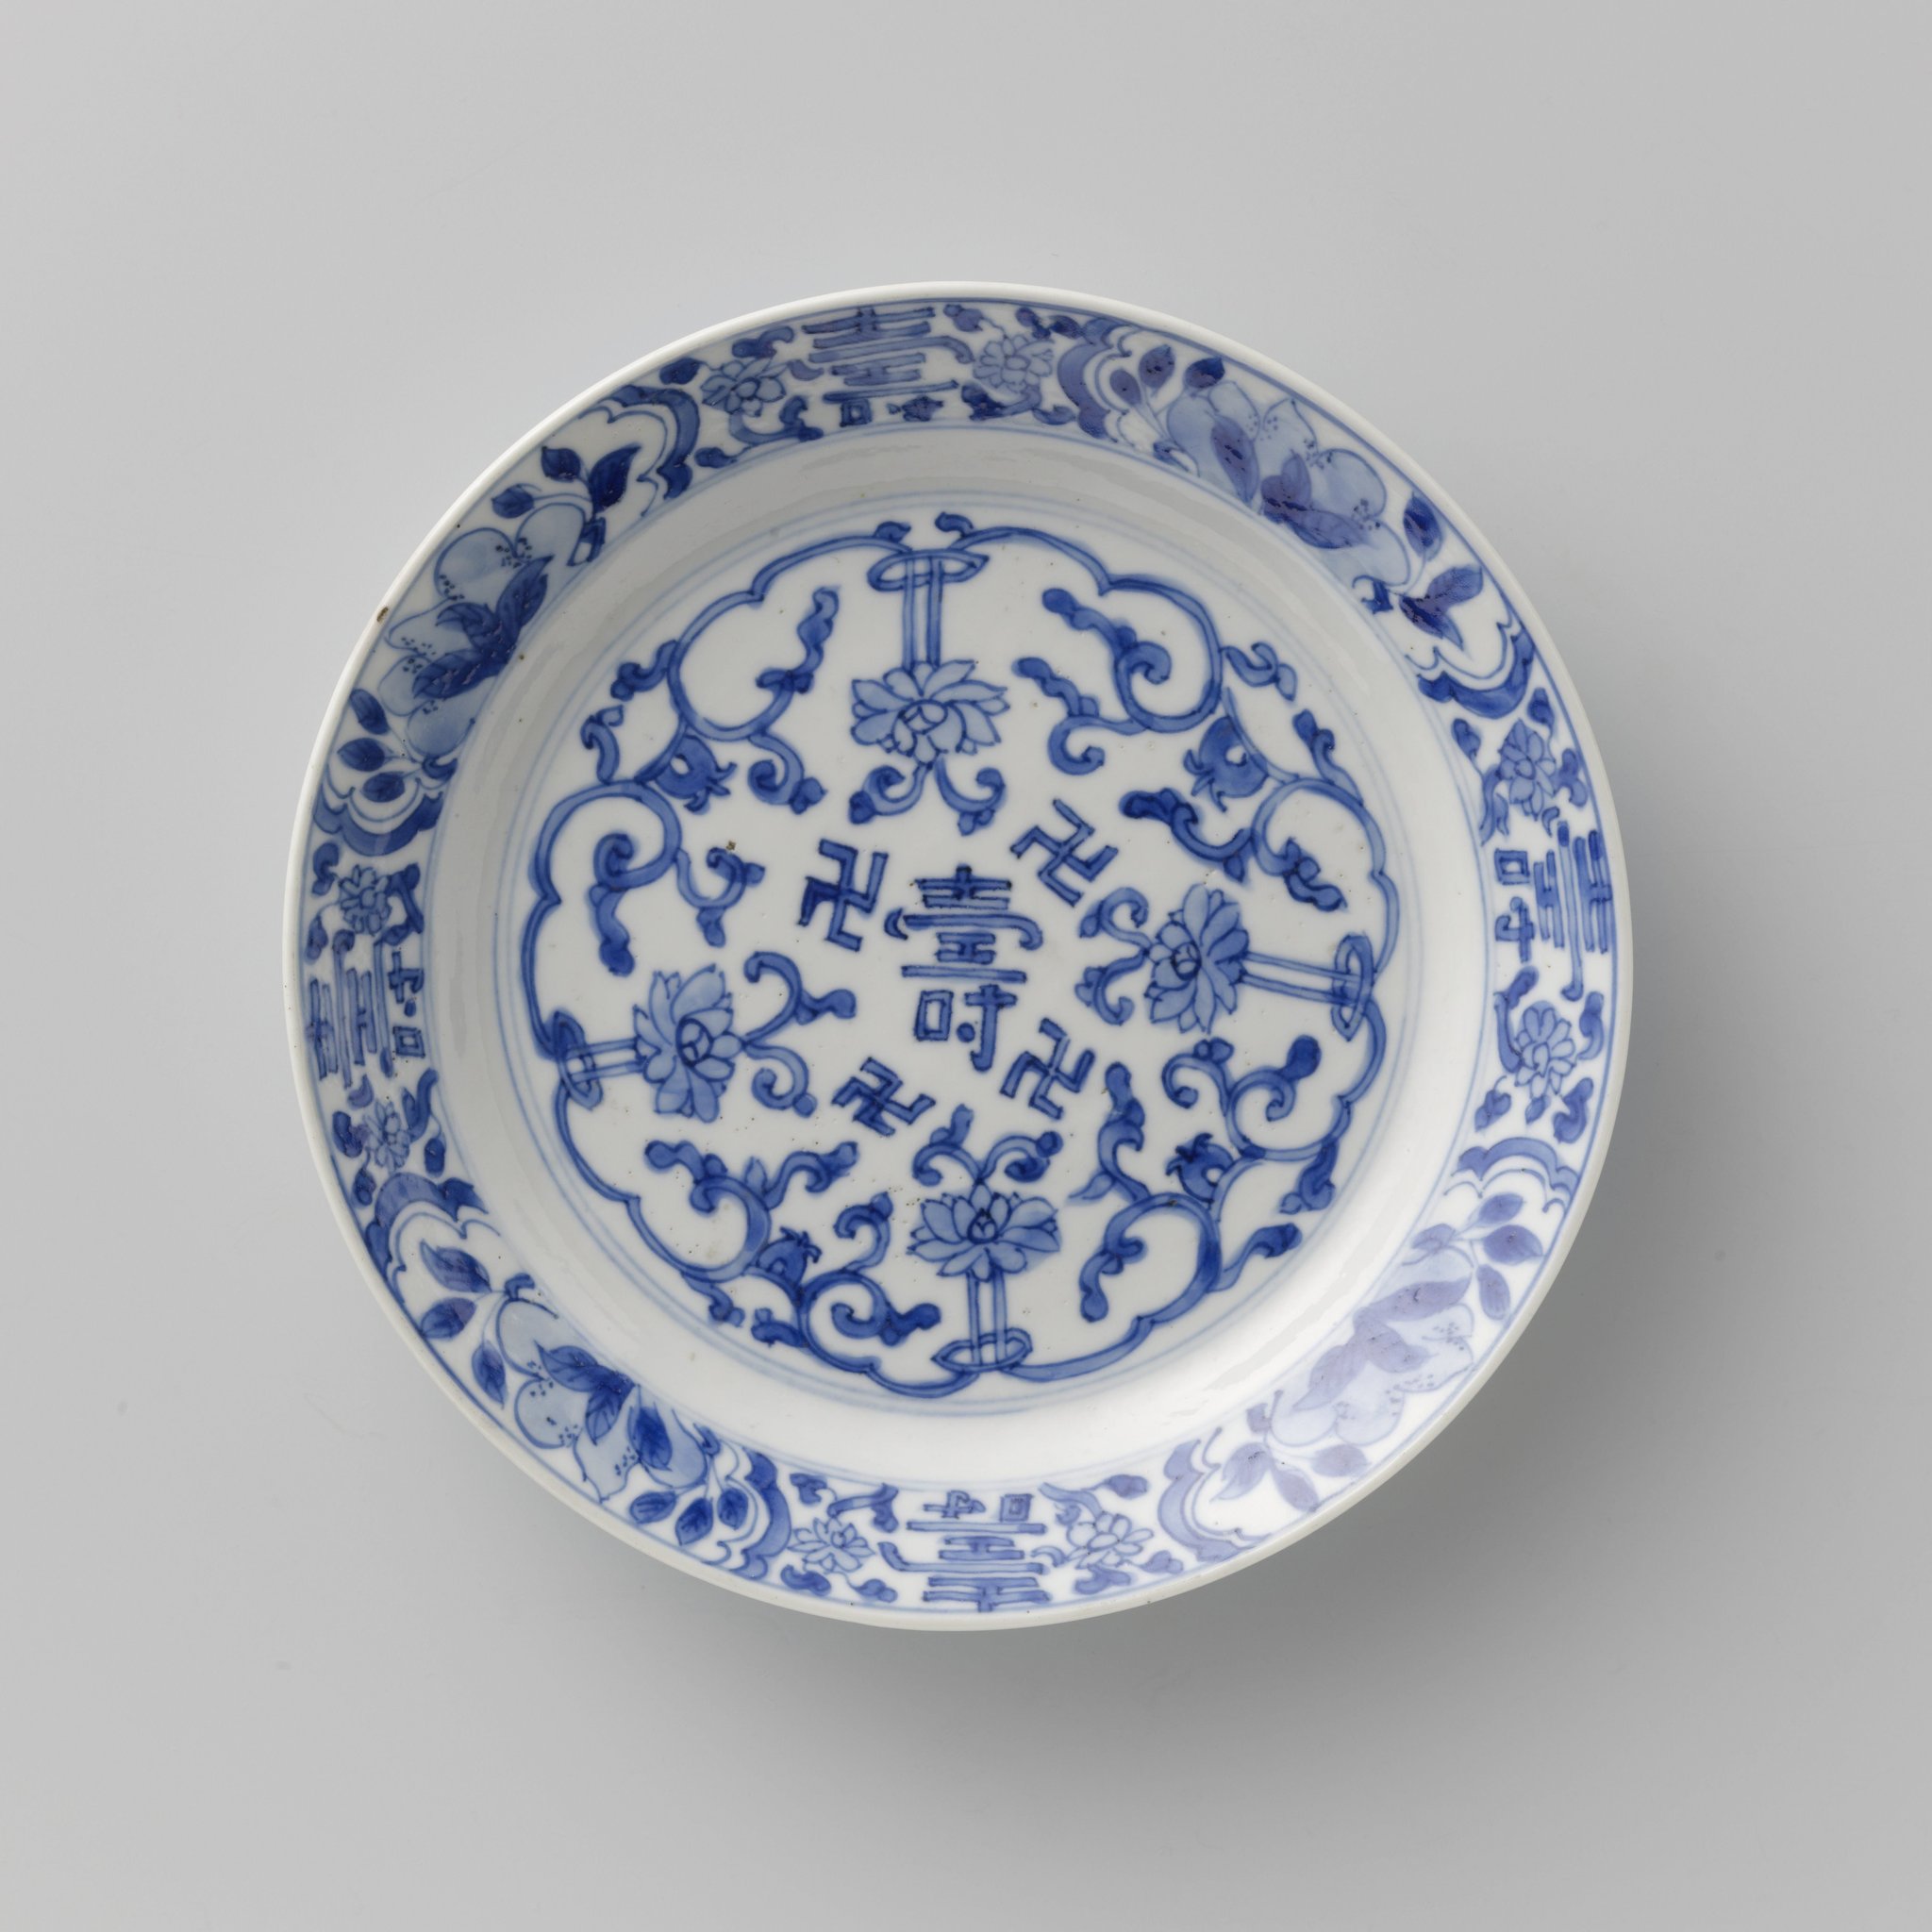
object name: plate dish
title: Plate with 'shou' character and stylised lotus scrolls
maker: Anonymous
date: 1680-1720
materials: cobalt, glaze, paint, porcelain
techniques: firing, turning, vitrification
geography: china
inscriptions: mark: ‘大 清 康 熙 年 製’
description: Bord, op plat vier gestileerde bloemen met tak en swastika-kruizen, platte rand met vier vakken met bloemen.